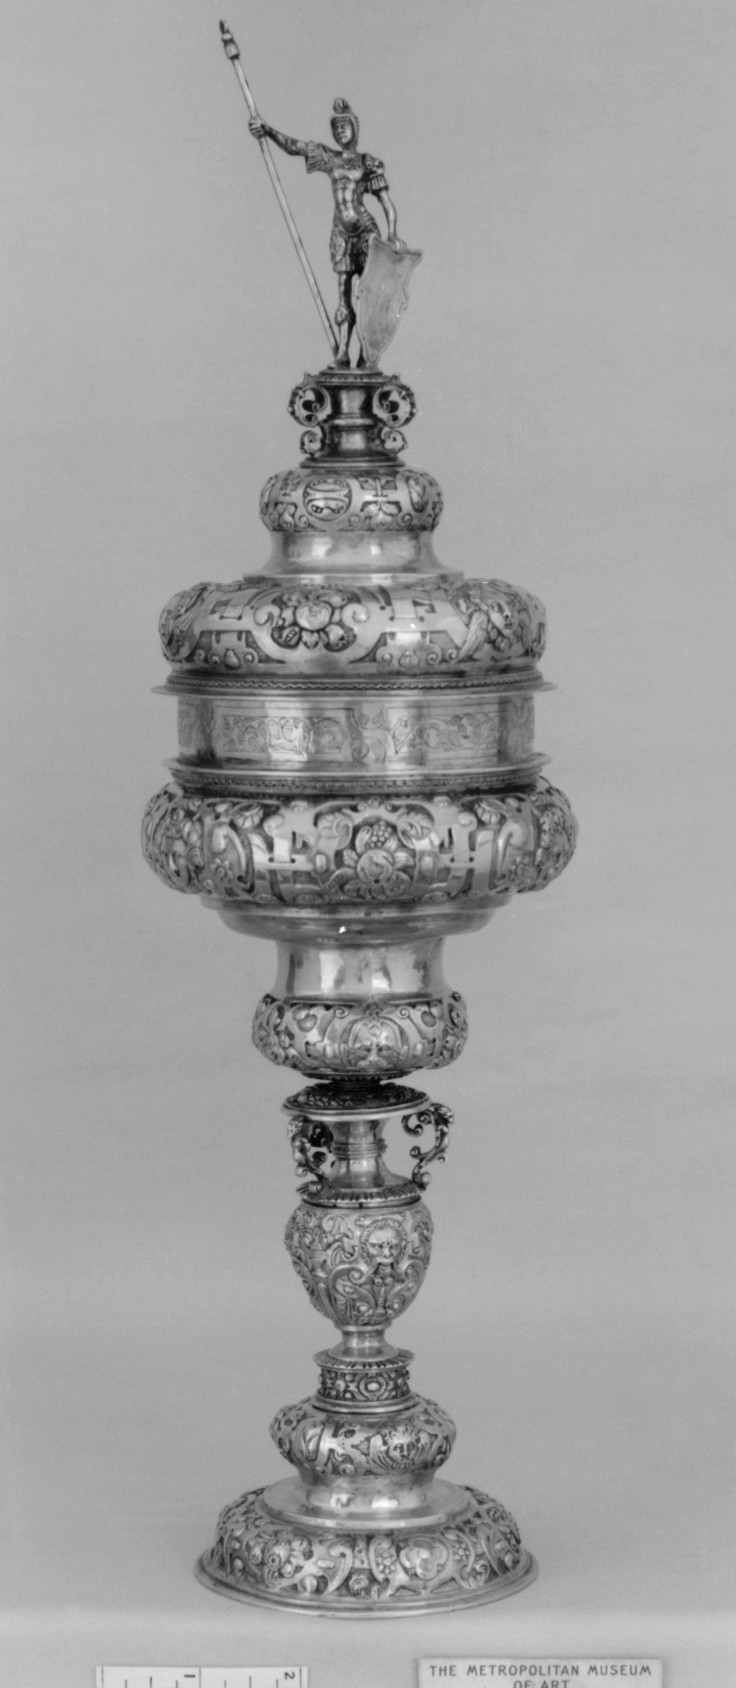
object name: standing cup with cover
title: Standing cup with cover (hanap)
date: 1501-1600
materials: silver gilt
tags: men